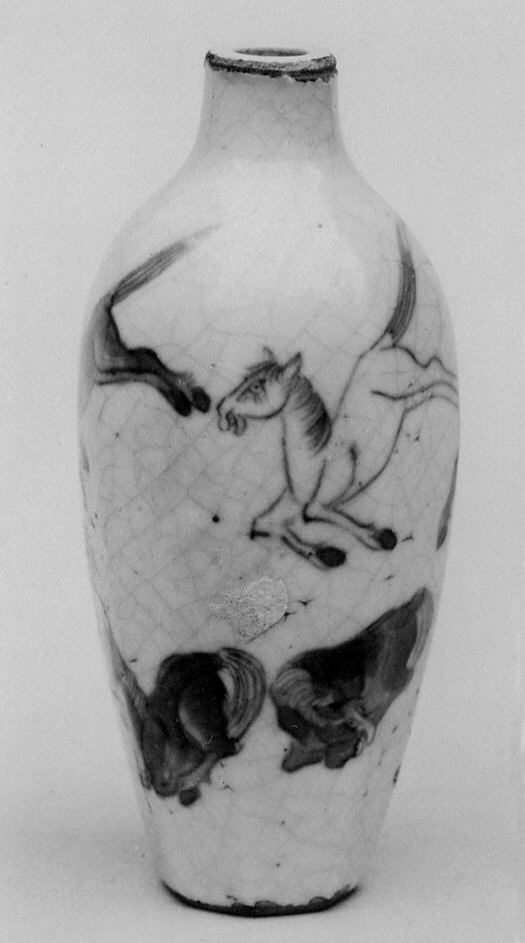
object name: snuff bottle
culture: chinese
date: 1701-1800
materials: porcelain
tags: horses